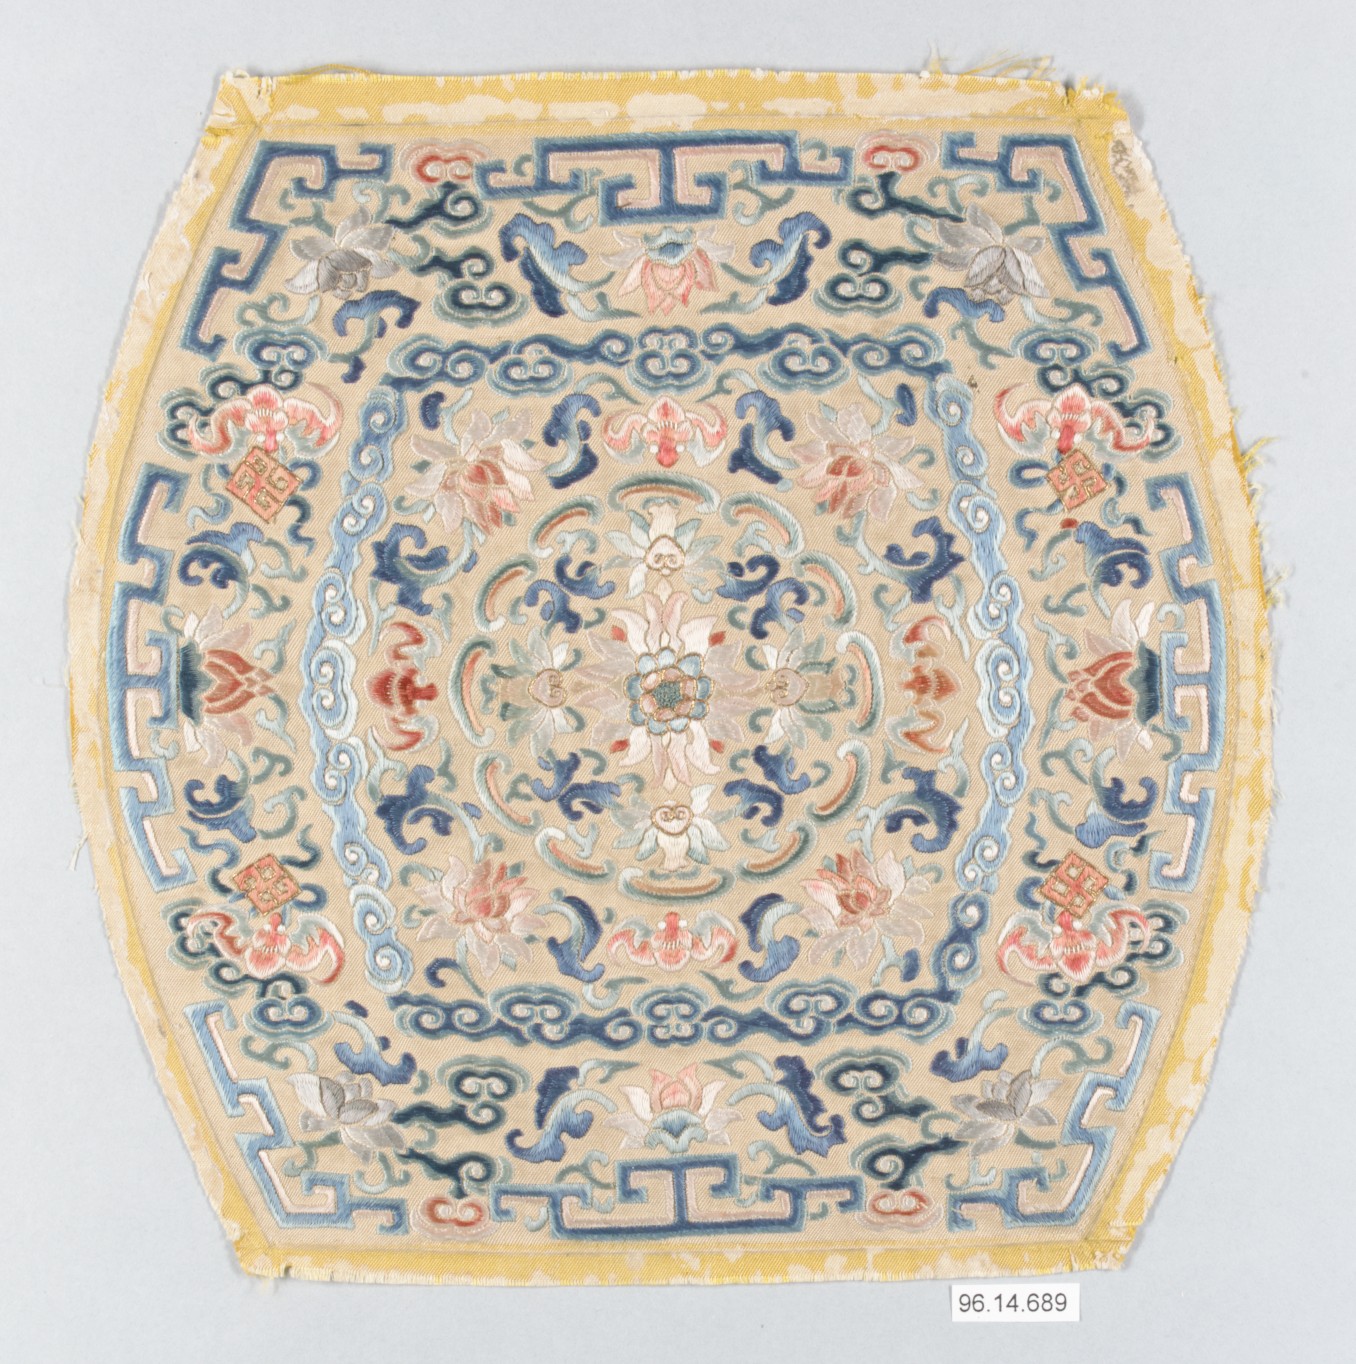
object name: piece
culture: chinese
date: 1701-1900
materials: metal thread, silk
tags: bats,flowers